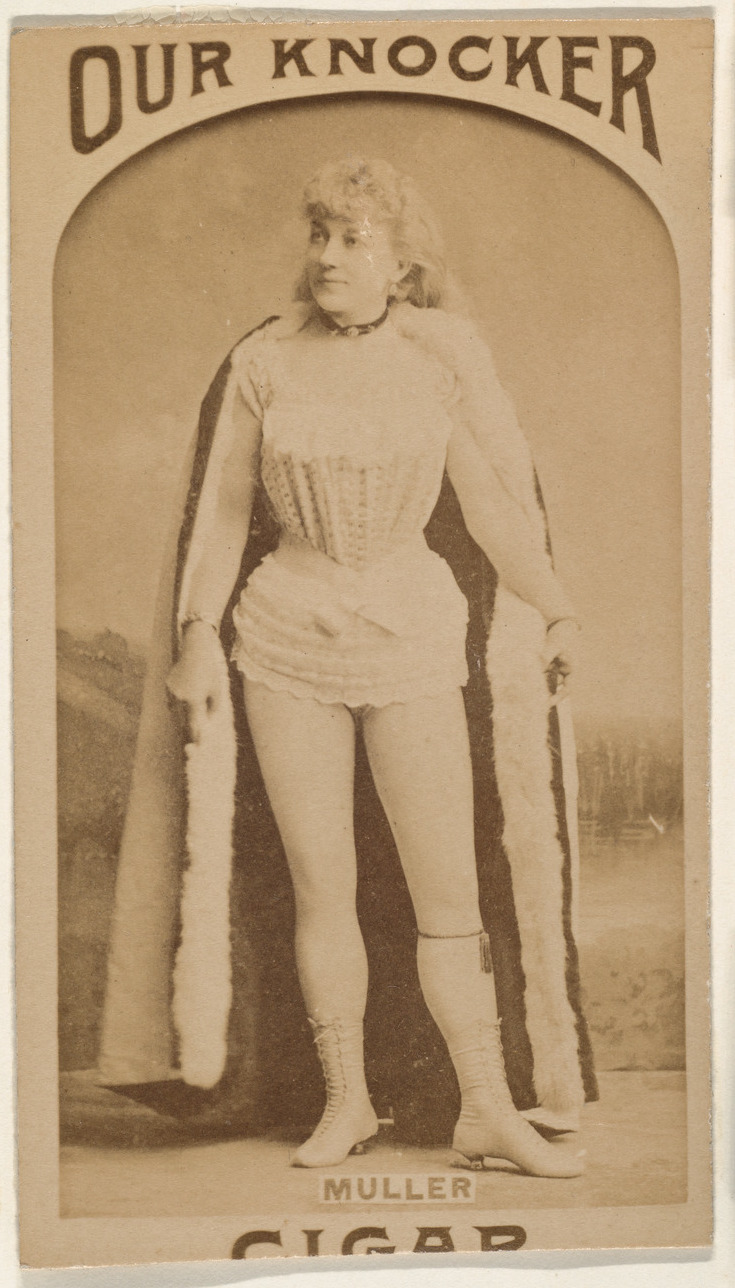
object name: photograph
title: Miss Muller, from the Actresses series (N665) promoting Our Knocker Cigars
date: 1888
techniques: albumen silver print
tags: portraits,women,actresses